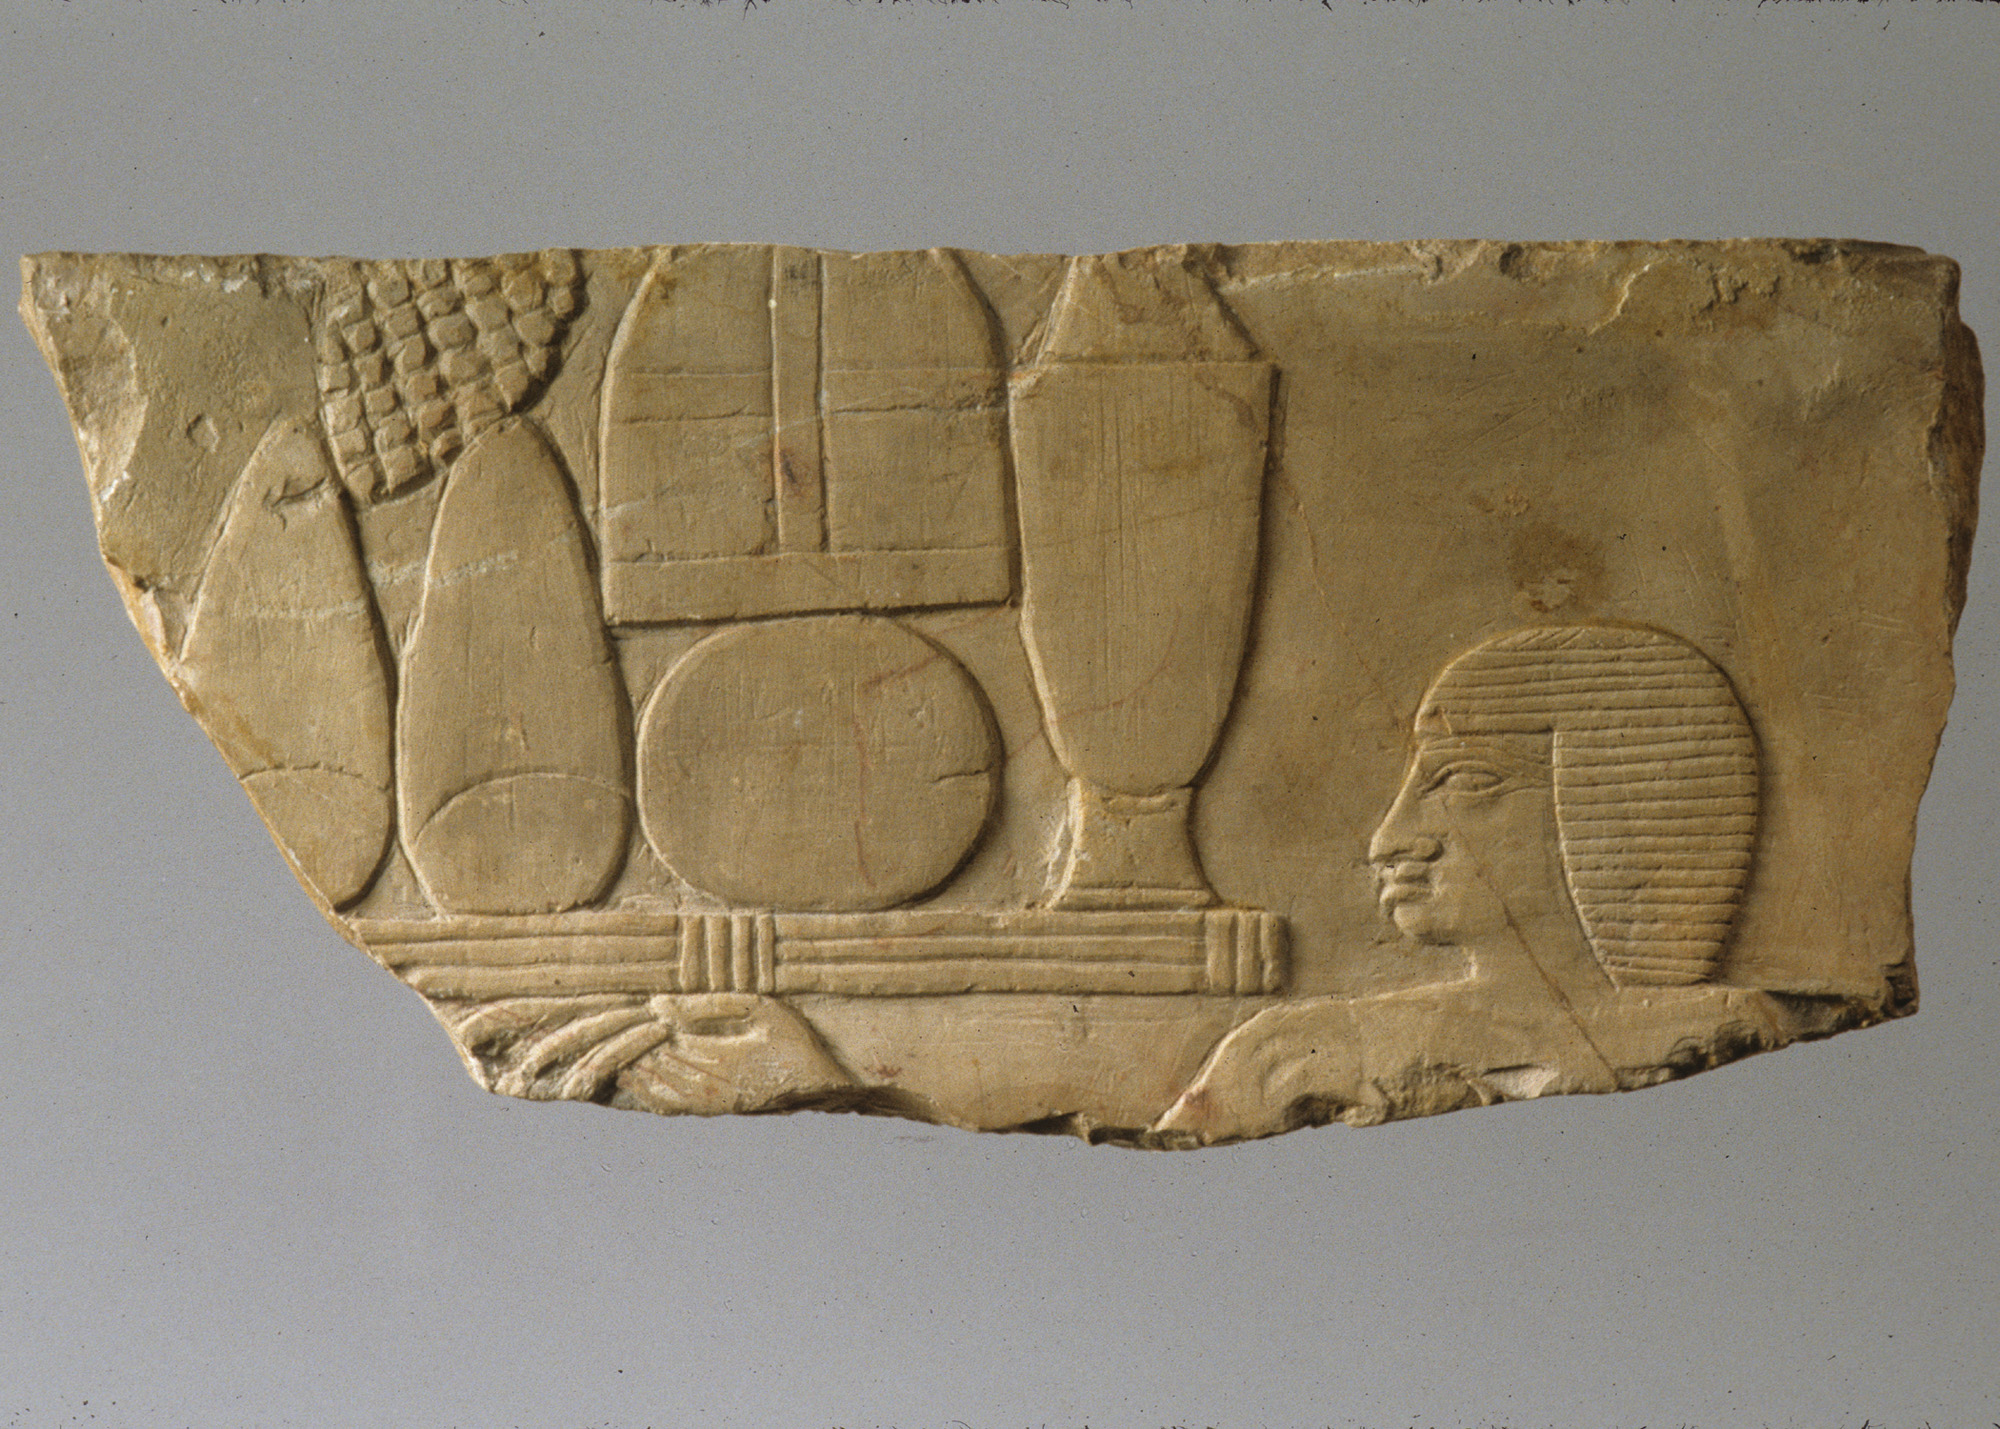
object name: relief, tomb of nespekashuty, head, offering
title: Raised relief fragment with head of an offering bearer and offerings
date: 664-610 BCE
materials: limestone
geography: egypt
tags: heads